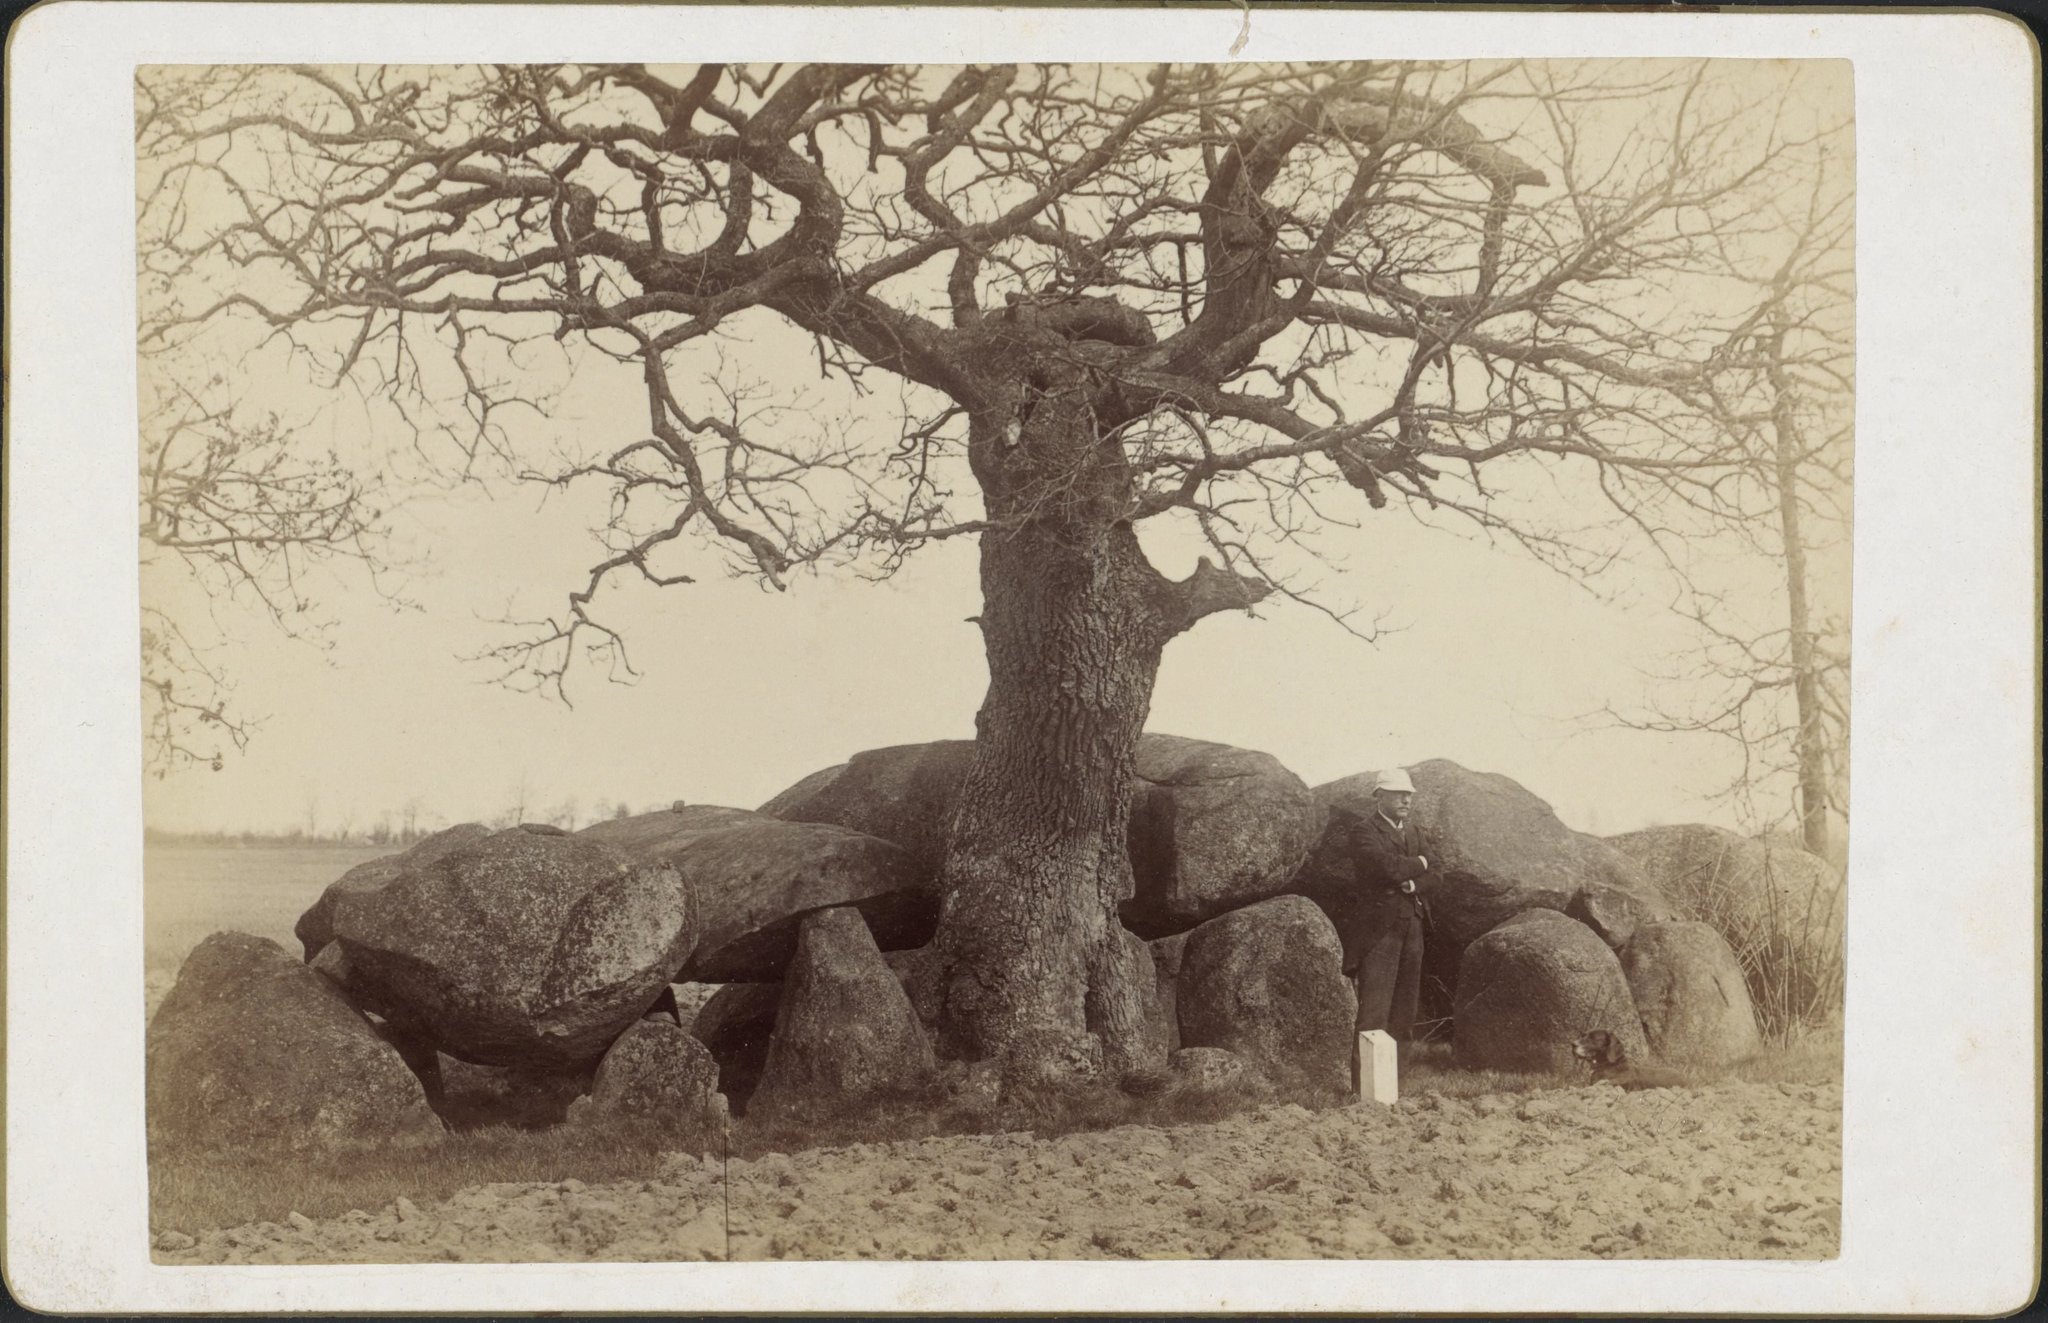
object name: cabinet photograph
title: Hunebed met eikeboom en staande man, Drenthe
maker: johannes gerardus kramer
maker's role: fotograaf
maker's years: 1845-1903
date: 1891-1896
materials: paper, photographic support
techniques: albumen print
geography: assen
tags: drenthe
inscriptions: annotation: ‘no 79.’, label: ‘VAN GORCUM & CO / A.D. BRINK/ ASSEN’